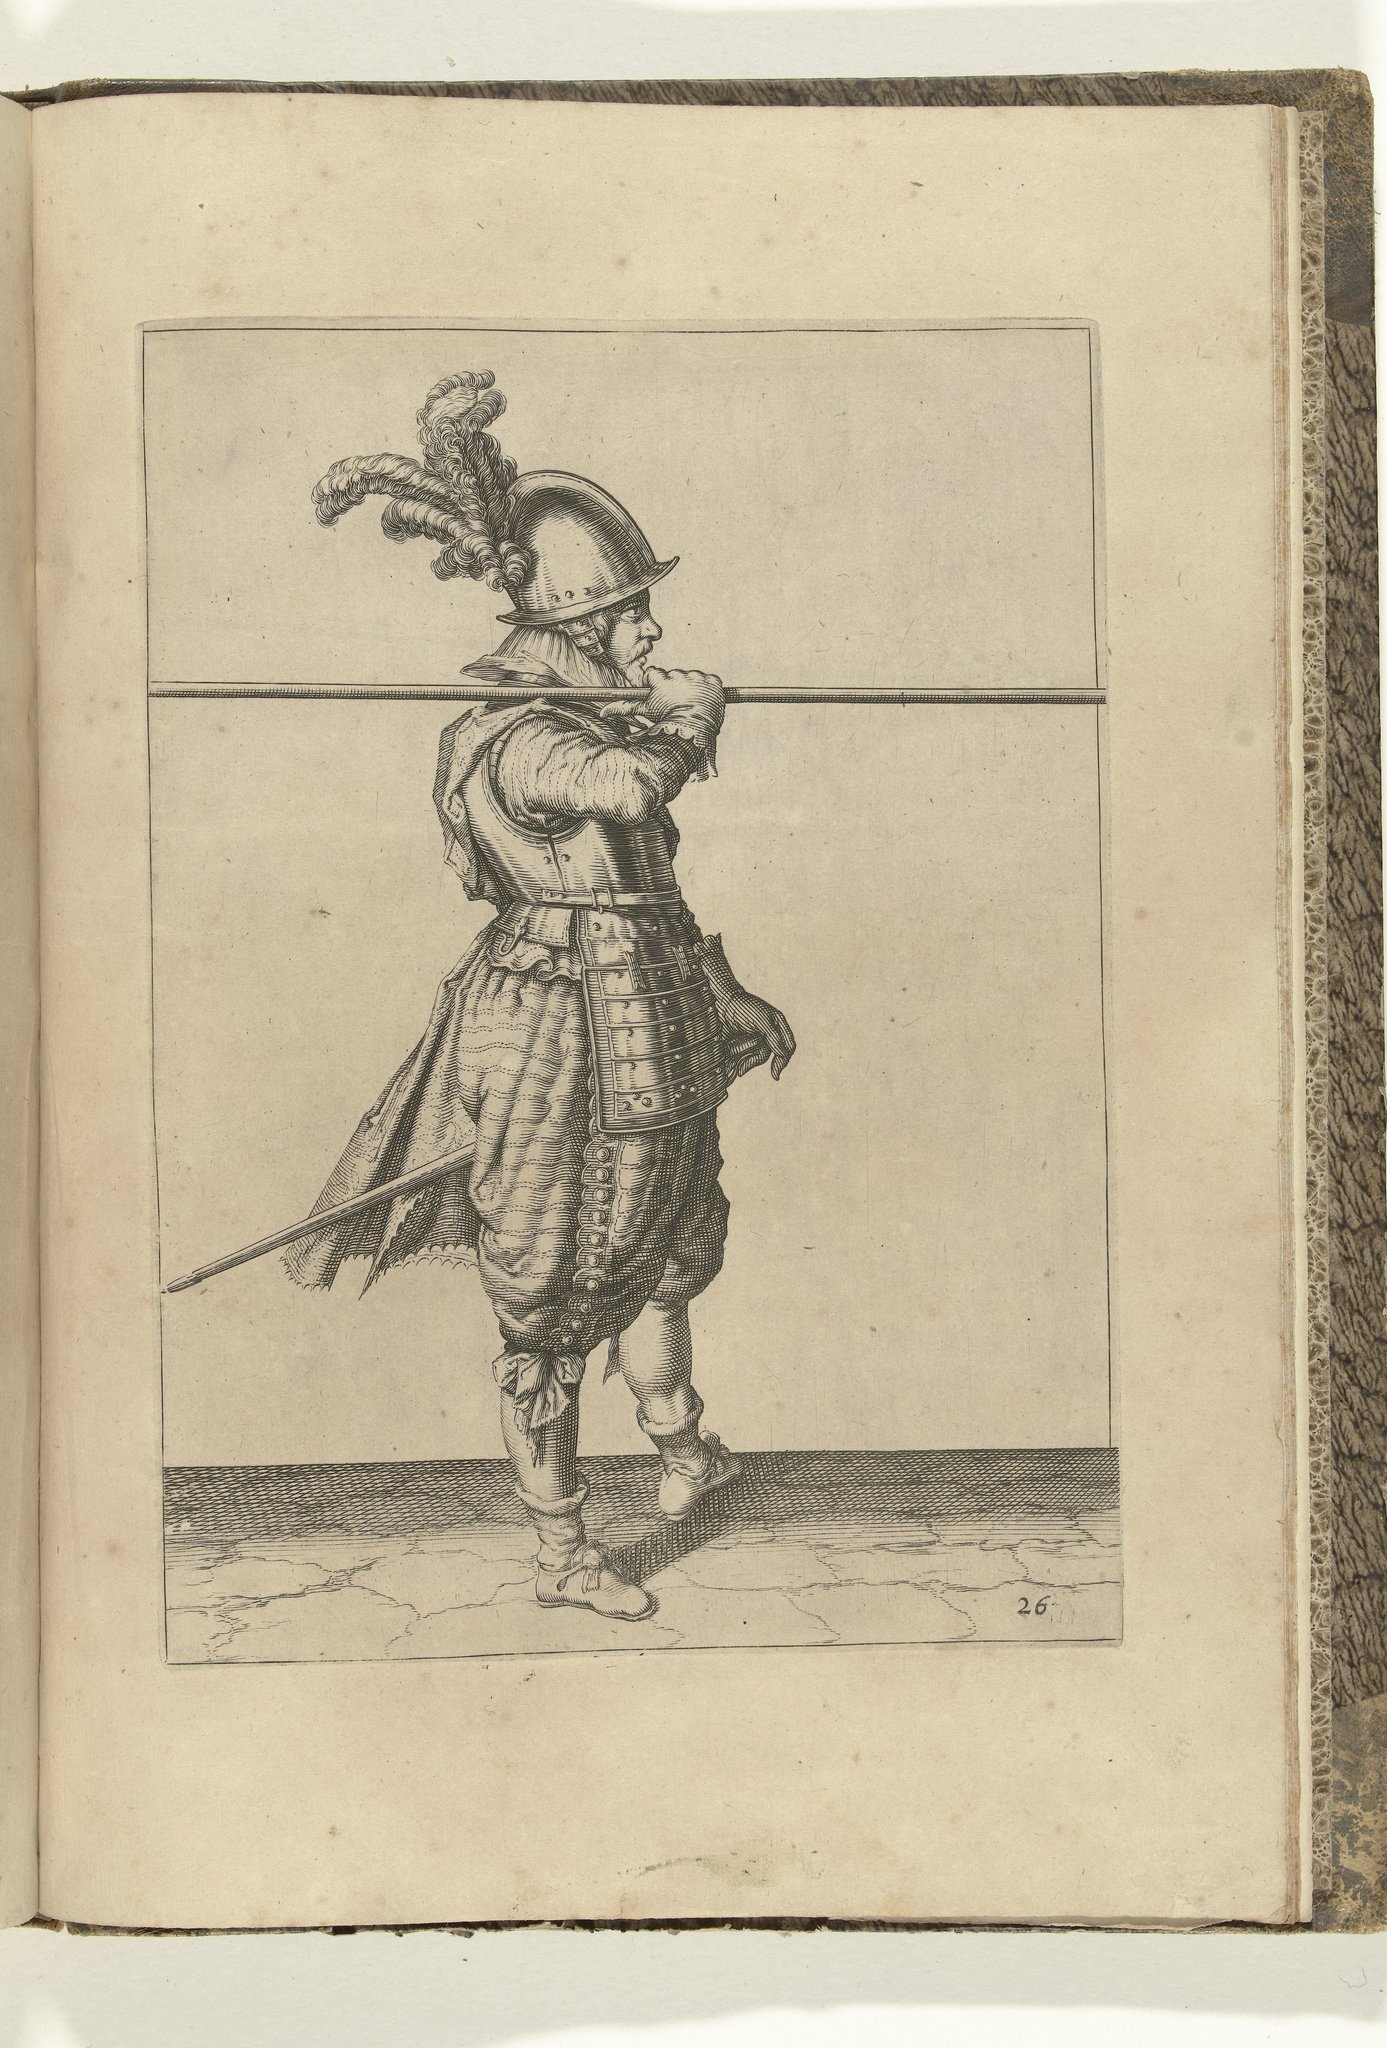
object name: print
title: Soldaat die zijn spies horizontaal op zijn rechterschouder draagt (nr. 26), ca. 1600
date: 1597-1608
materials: paper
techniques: engraving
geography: northern netherlands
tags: the hague, maurice (prince of orange), handling of weapons ~ military training, weapons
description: Een soldaat, ten voeten uit, naar rechts, die een spies (lans) horizontaal op zijn rechterschouder draagt. Zijn rechterhand om de spies (nr. 26), ca. 1600. Eerst fout genummerd 24, dit cijfer hier verbeterd in 26. Plaat 26 in de instructies voor het hanteren van de spies: Enseignement brief; et succint sur les portraitz figurez, touchant l'usage, de tout ce qu'un Soldat doibt faire au maniement de la Pique. Onderdeel van de illustraties in een Franse editie van J. de Gheyns Wapenhandelinghe: J. de Gheyn, Maniement d'armes, d'arquebuses, mousquetz et piques : en conformité de l'ordre de Mour le Prince Maurice, Prince d'Orange, Amsterdam 1608. Krijgswezen rond 1600.